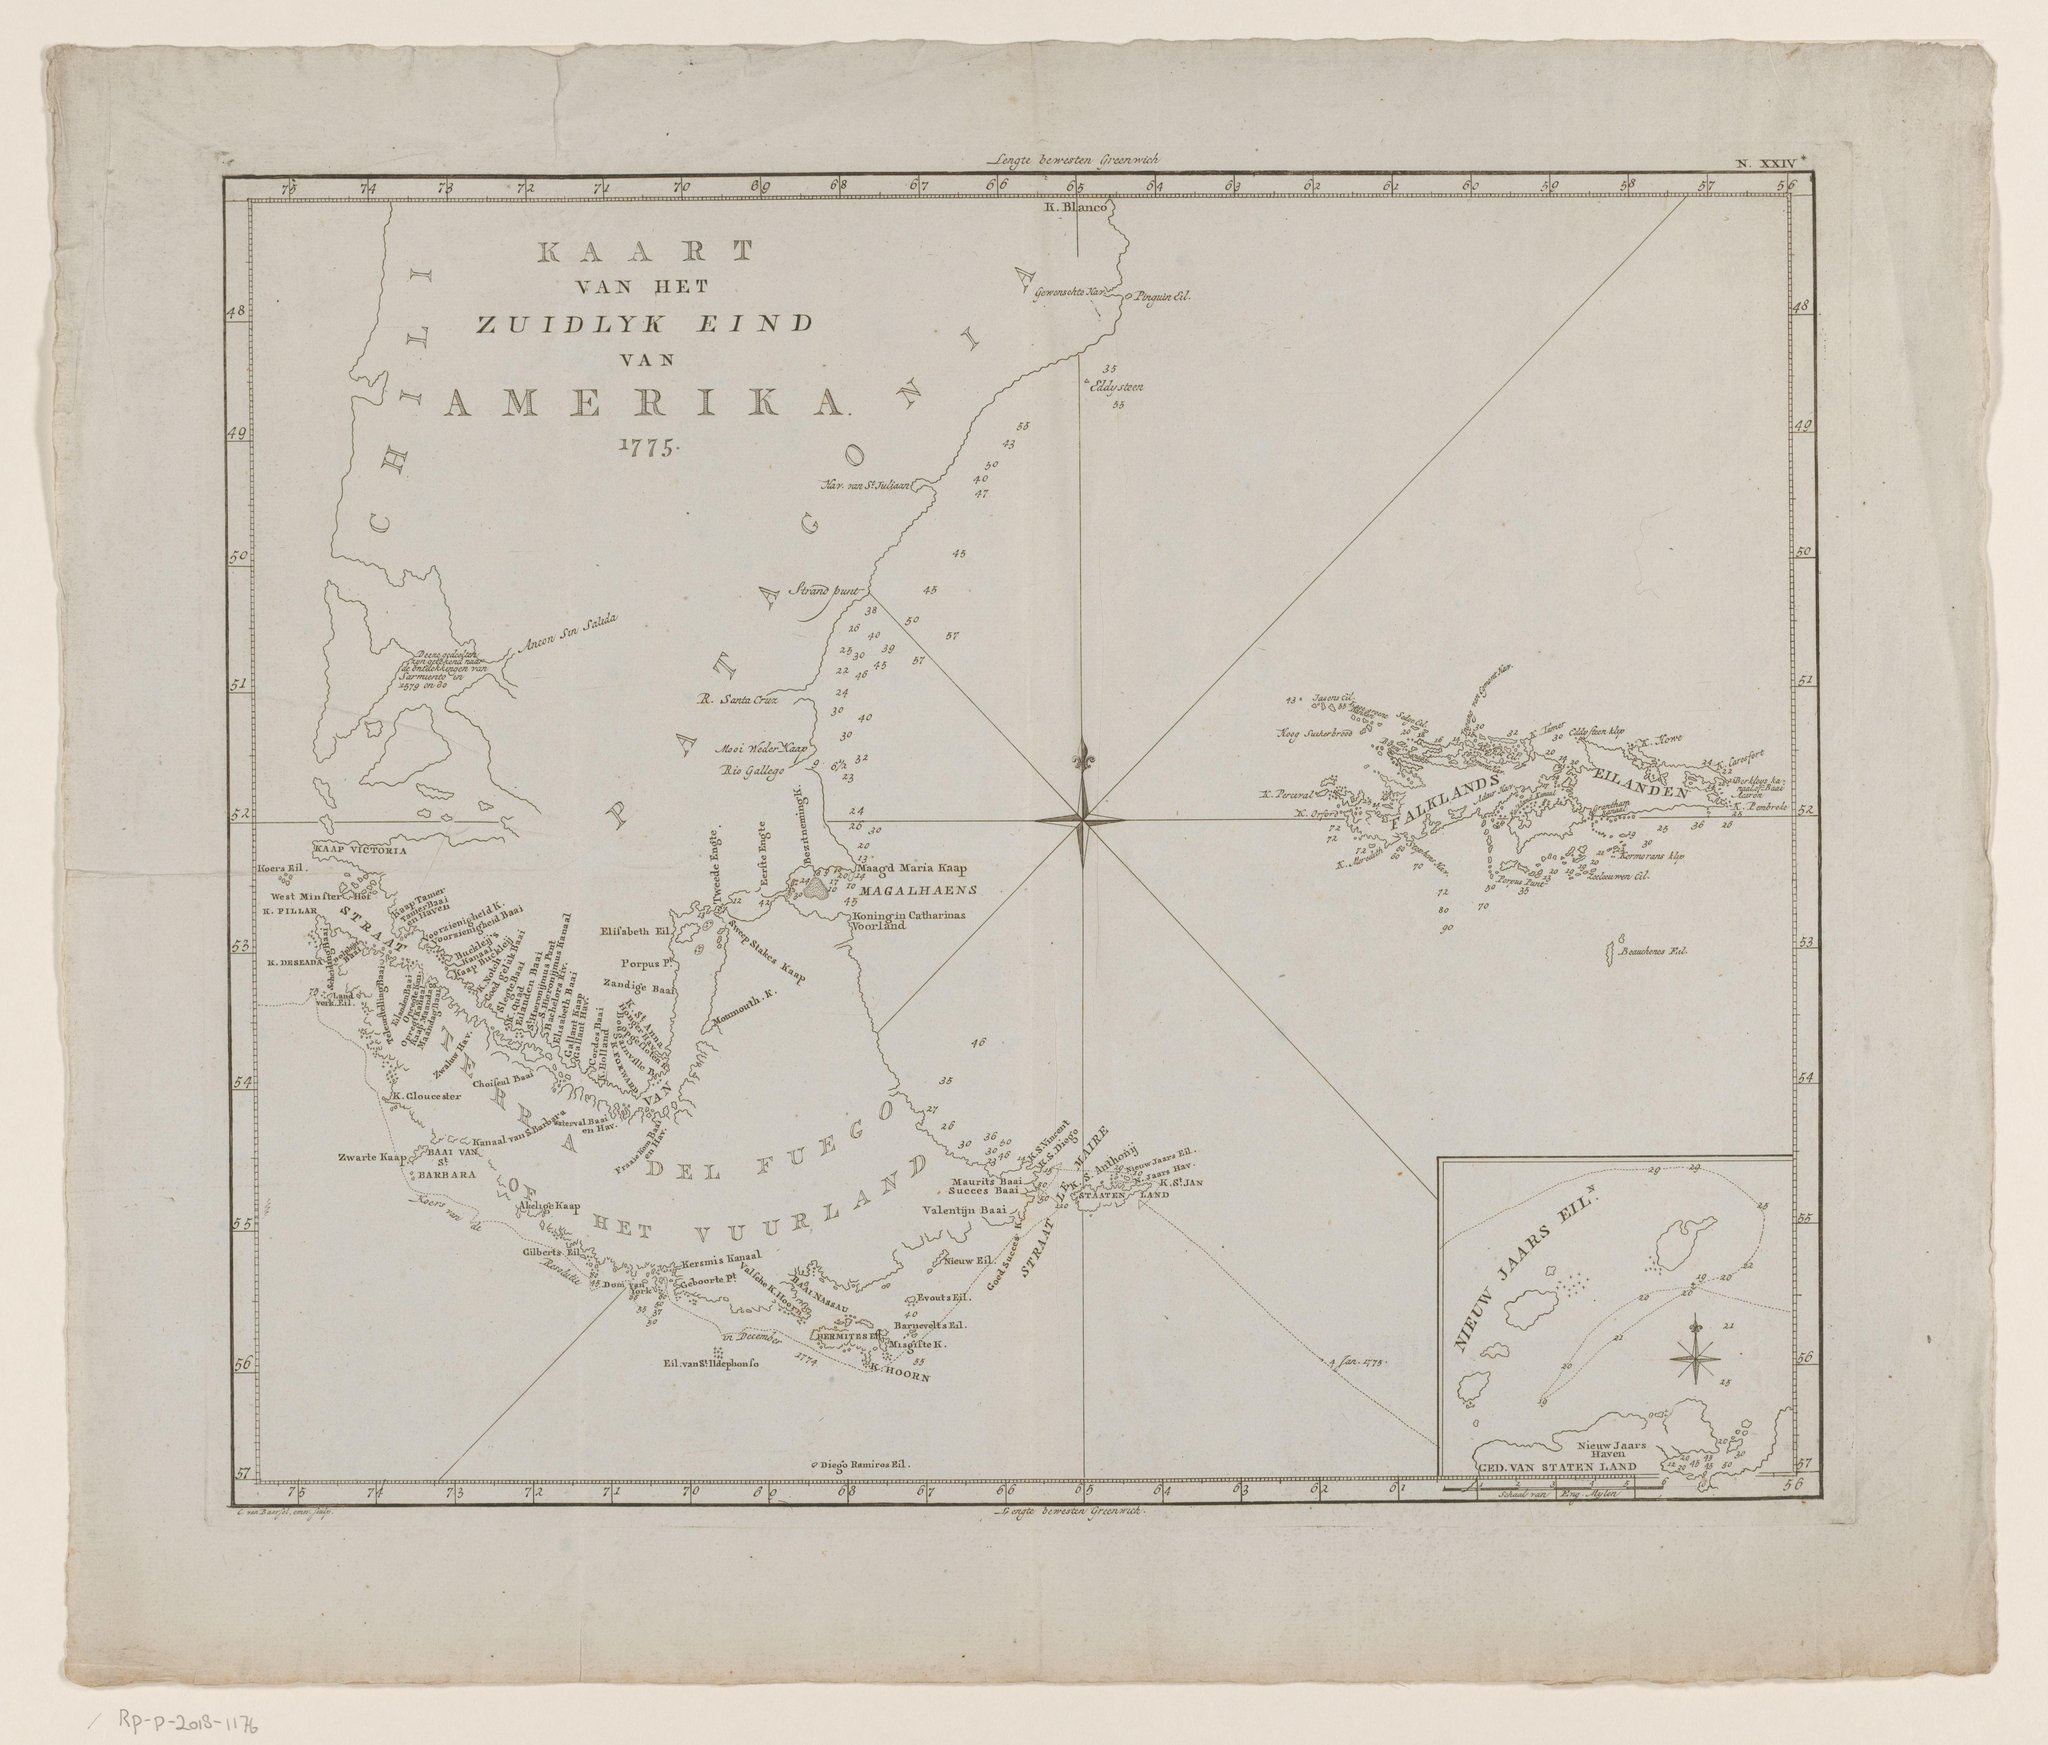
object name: print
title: Kaart van het meest zuidelijke punt van Zuid-Amerika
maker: cornelis van baarsel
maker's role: print maker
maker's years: 1761-1826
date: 1795-1809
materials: paper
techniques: engraving, etching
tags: fortress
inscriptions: collector's mark: Lugt 2228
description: Prent ook gebruikt in: Cook, James. Reize rondom de waereld. 13 dln. Amsterdam: Isaak vn Cleef, Leiden: Jan en Abraham Honkoop, Den Haag: Johannes Allart, 1795-1809.